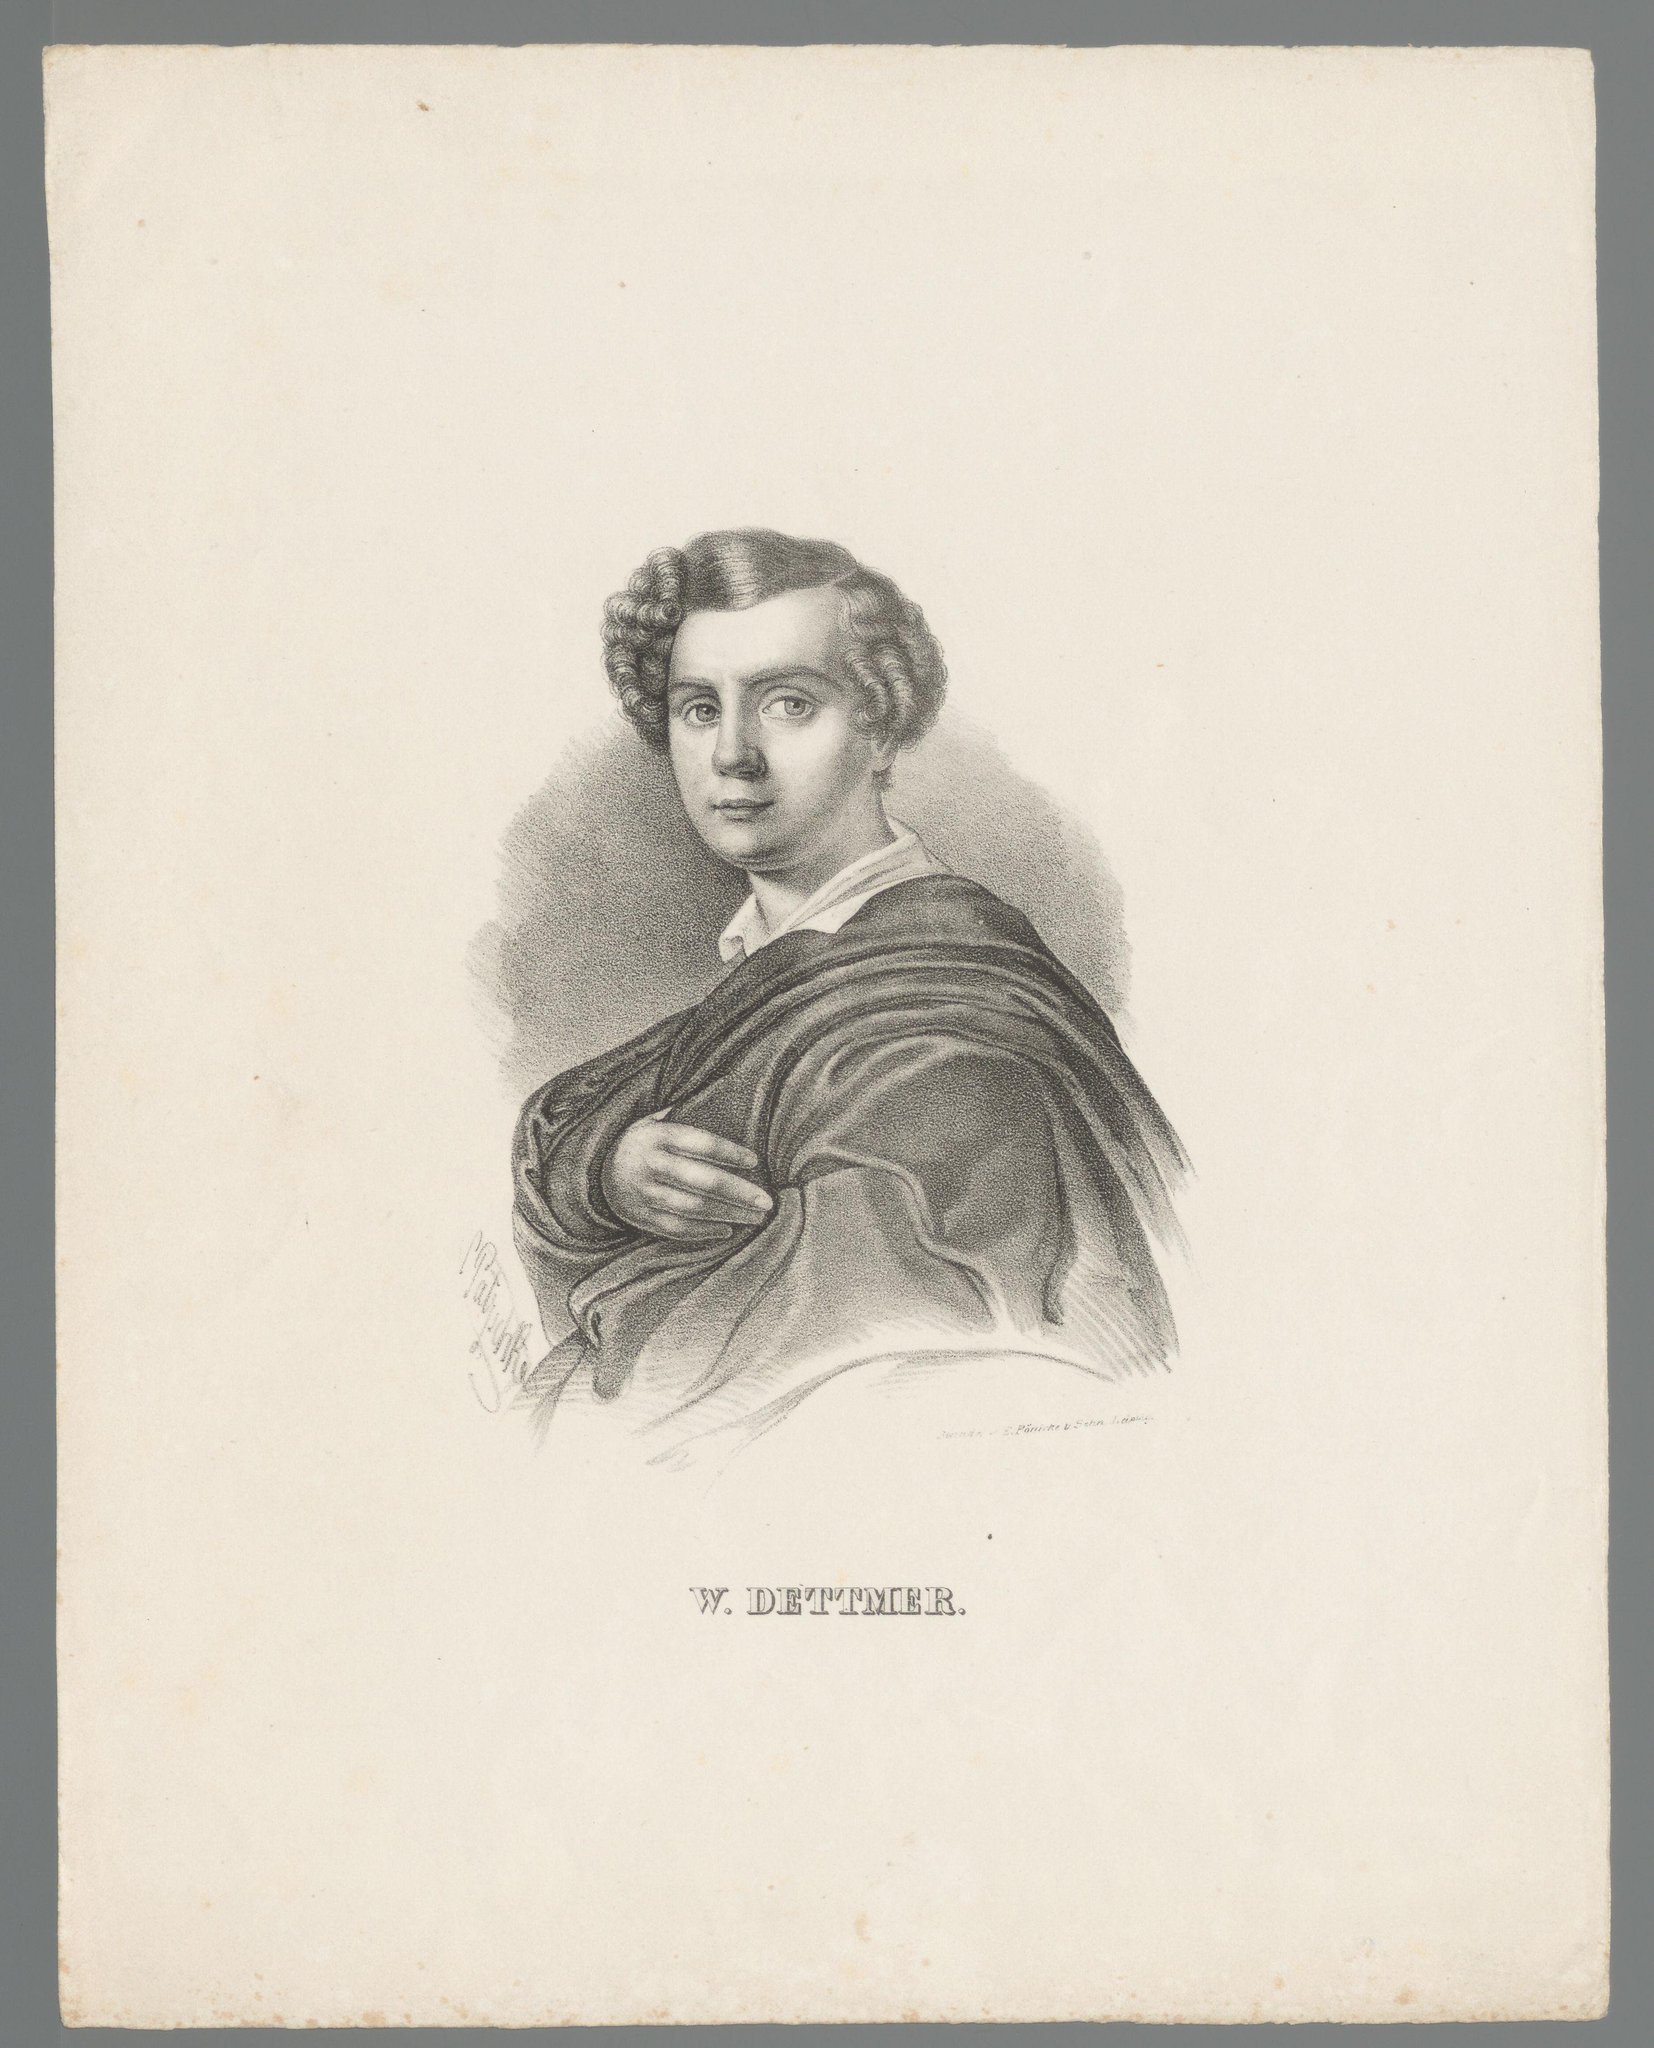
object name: print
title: Portret van een man, waarschijnlijk Georg Wilhelm Dettmer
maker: carl friedrich patzschke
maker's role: print maker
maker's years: 1813-1871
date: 1823-1871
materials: paper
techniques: lithograph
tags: adult man, historical persons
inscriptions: collector's mark: Lugt 2228